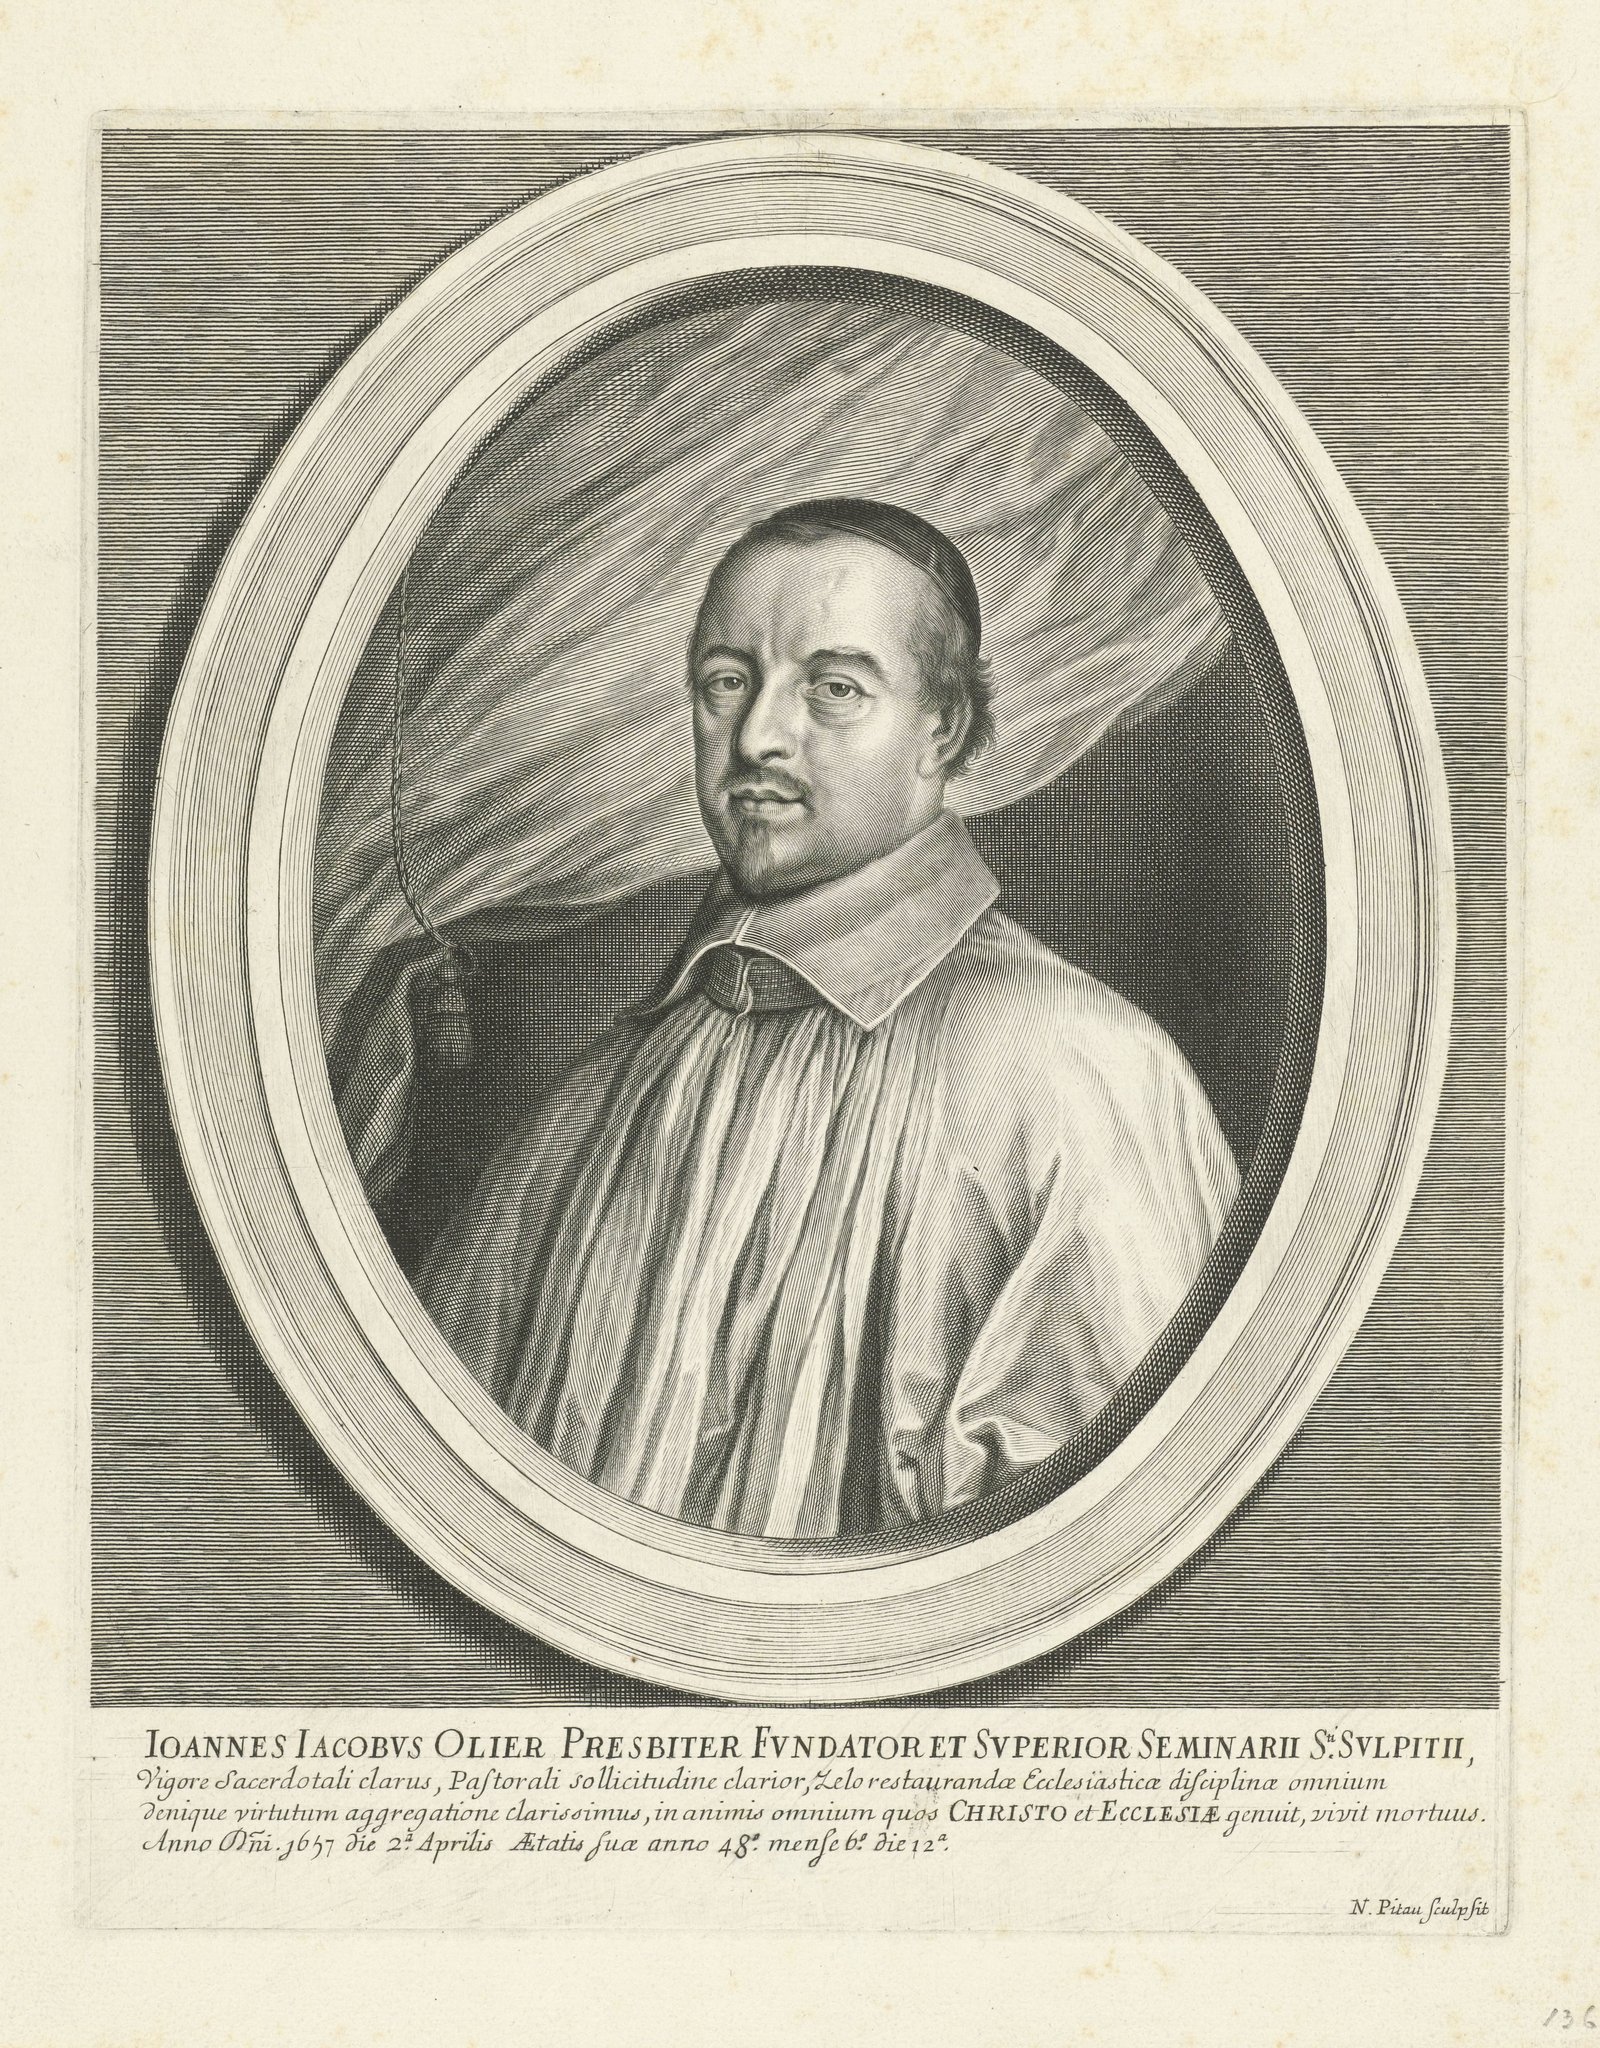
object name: print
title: Portret van Jean Jacques Olier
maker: nicolas pitau (i)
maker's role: print maker, publisher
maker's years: 1632-1671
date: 1644-1671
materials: paper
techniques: engraving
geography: paris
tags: priest (roman catholic)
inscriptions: collector's mark: Lugt 2228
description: Portret van de priester Jean Jacques Olier, op 48-jarige leeftijd. In de marge een vierregelig onderschrift in het Latijn.